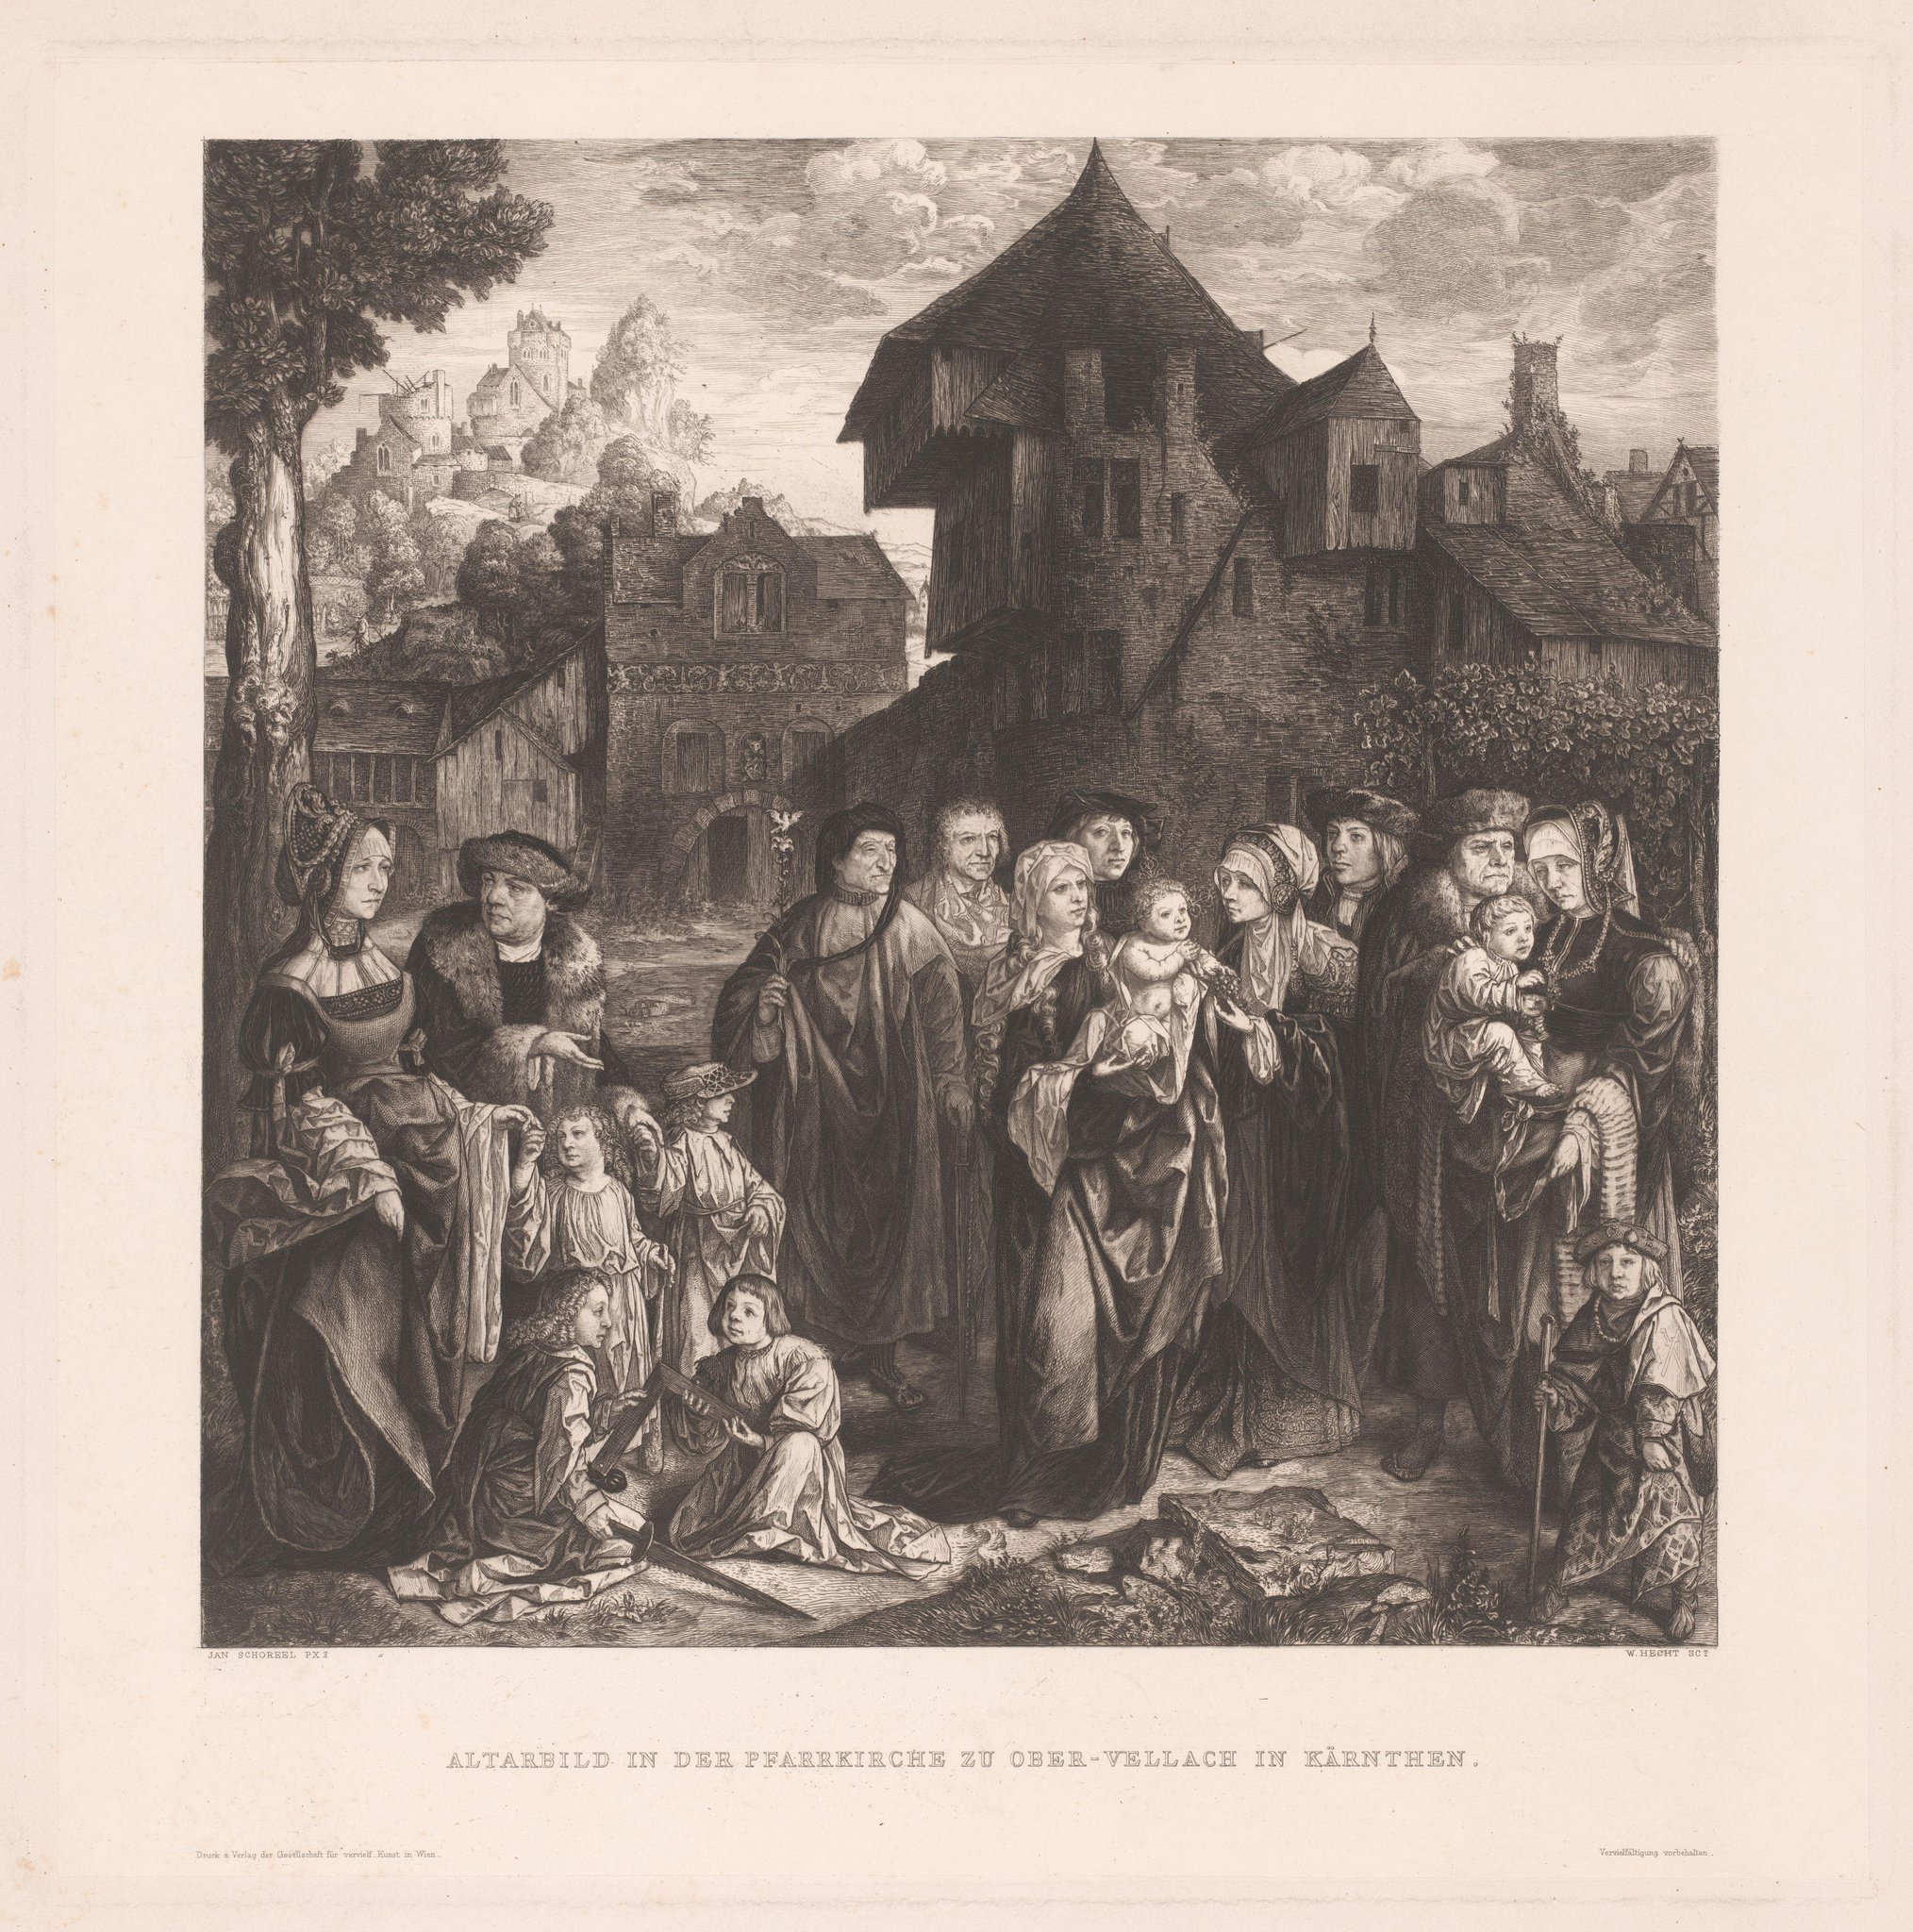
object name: print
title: Stadsgezicht met de heilige familie en schenkers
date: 1871-1907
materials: paper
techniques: etching, intaglio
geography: vienna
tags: city-view in general; 'veduta', holy family with john the baptist; elisabeth and zacharias present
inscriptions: collector's mark: Lugt 2228